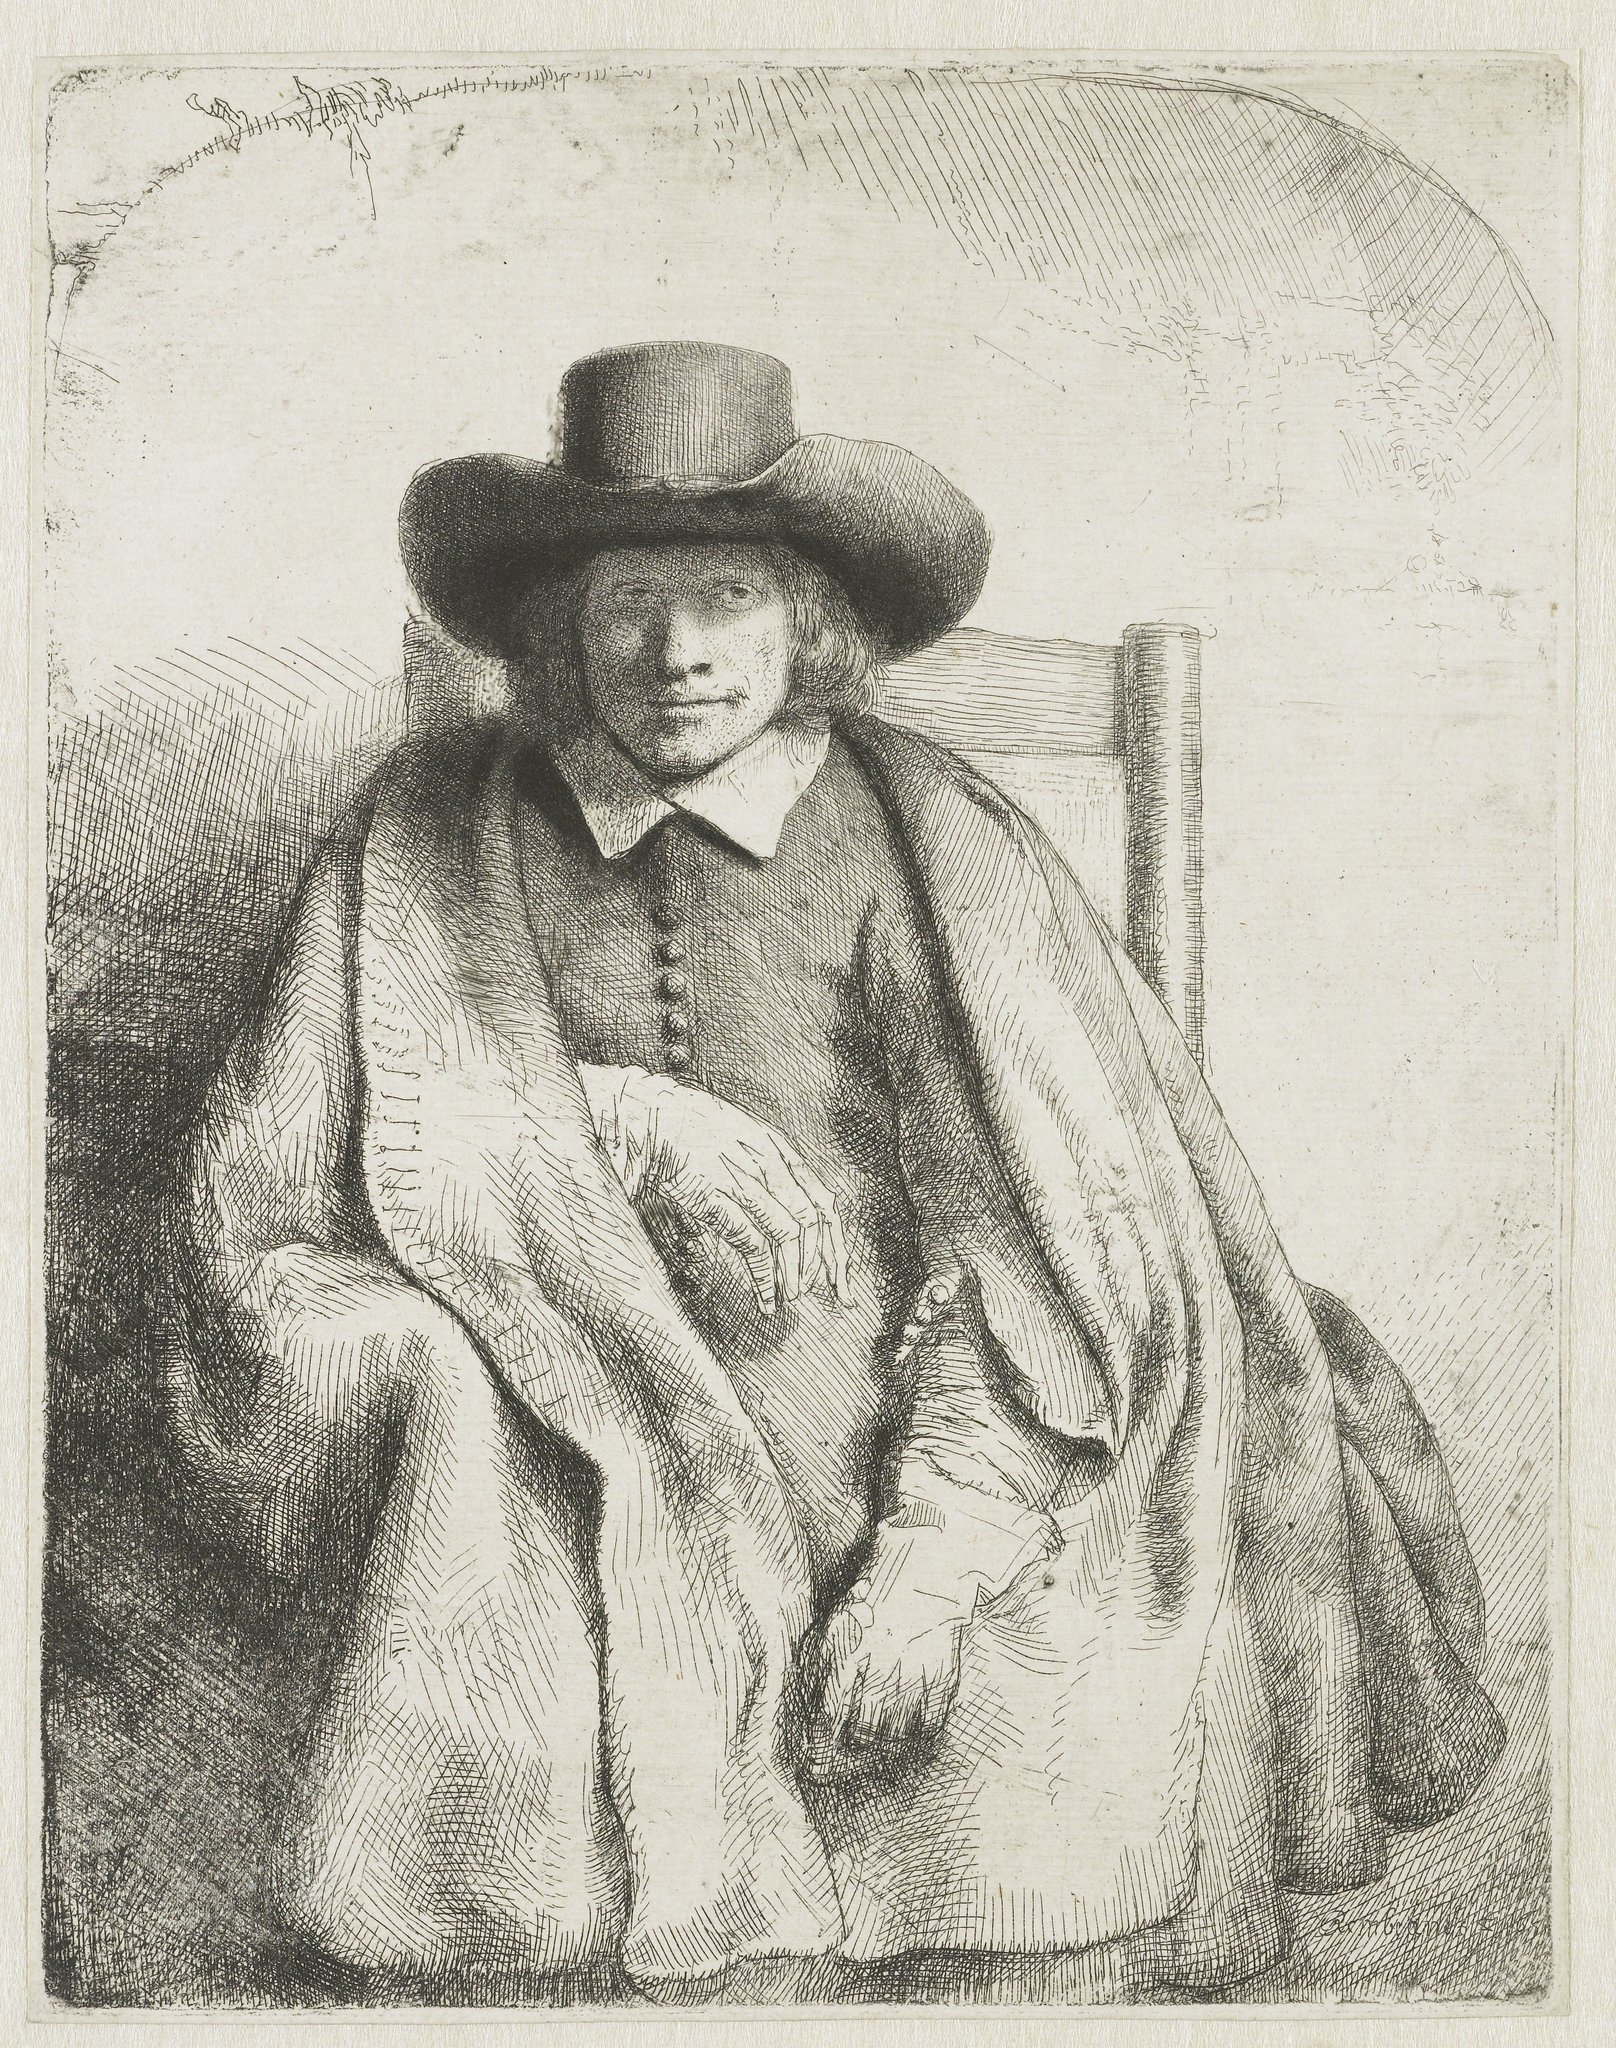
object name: print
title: Clement de Jonghe, printseller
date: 1651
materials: paper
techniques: drypoint, etching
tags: germany, amsterdam, publisher, clement de jonghe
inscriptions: collector's mark: Lugt 2228 a, inscription: ‘>v z’, inscription: ‘a 37480’, inscription: ‘Fbx’, collector's mark: Lugt 822, inscription: ‘8379’, inscription: ‘4617’, signature and date: ‘Rembrandt f 1651’